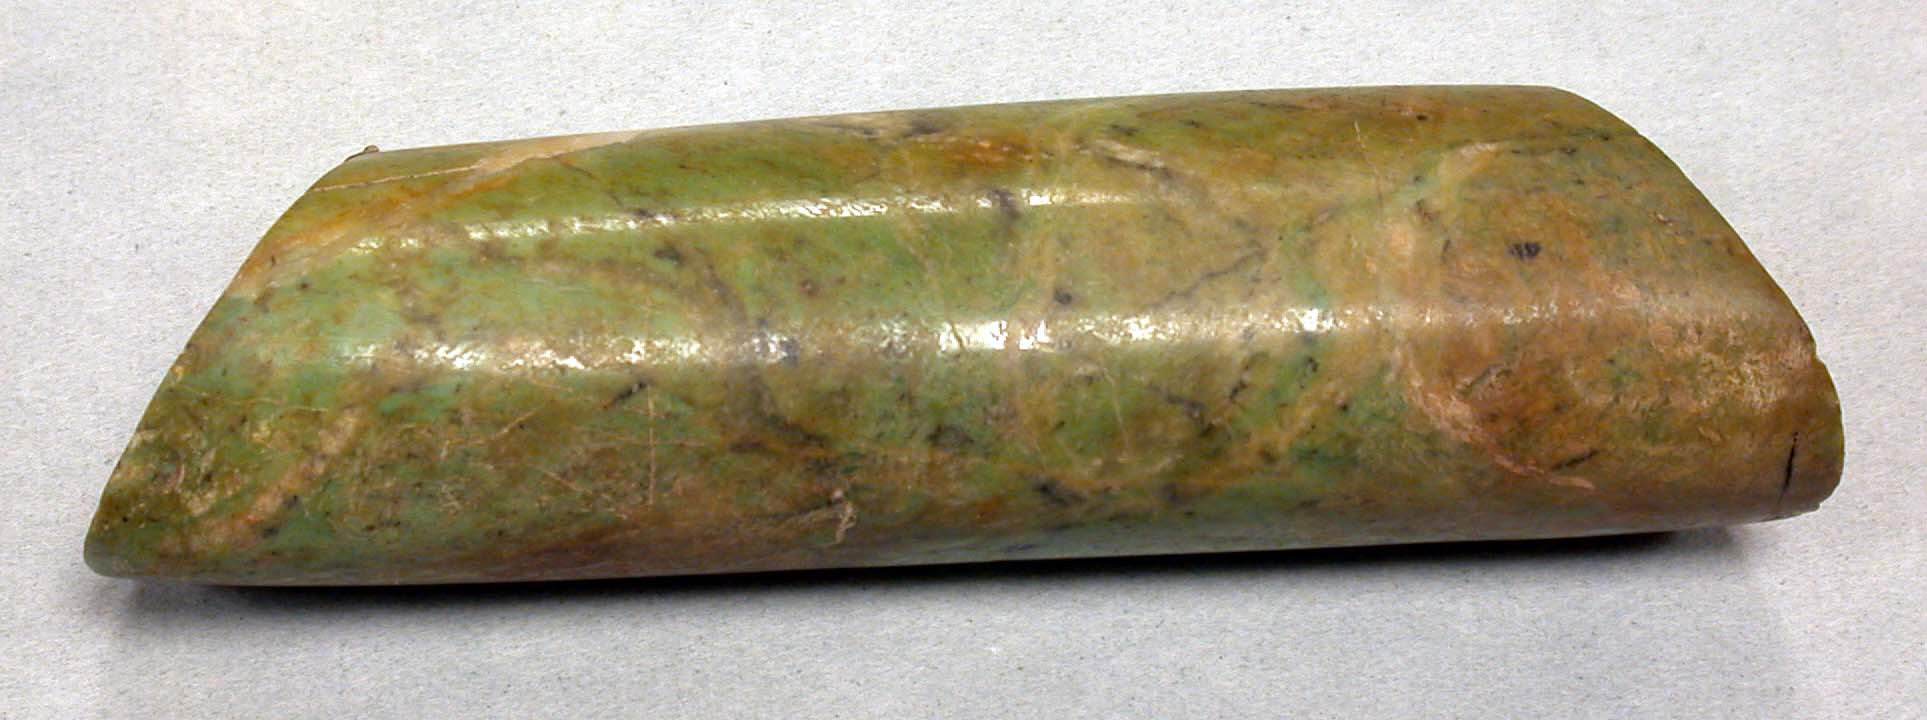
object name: bead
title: Tubular Bead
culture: olmec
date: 1000-301 BCE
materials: stone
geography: mexico